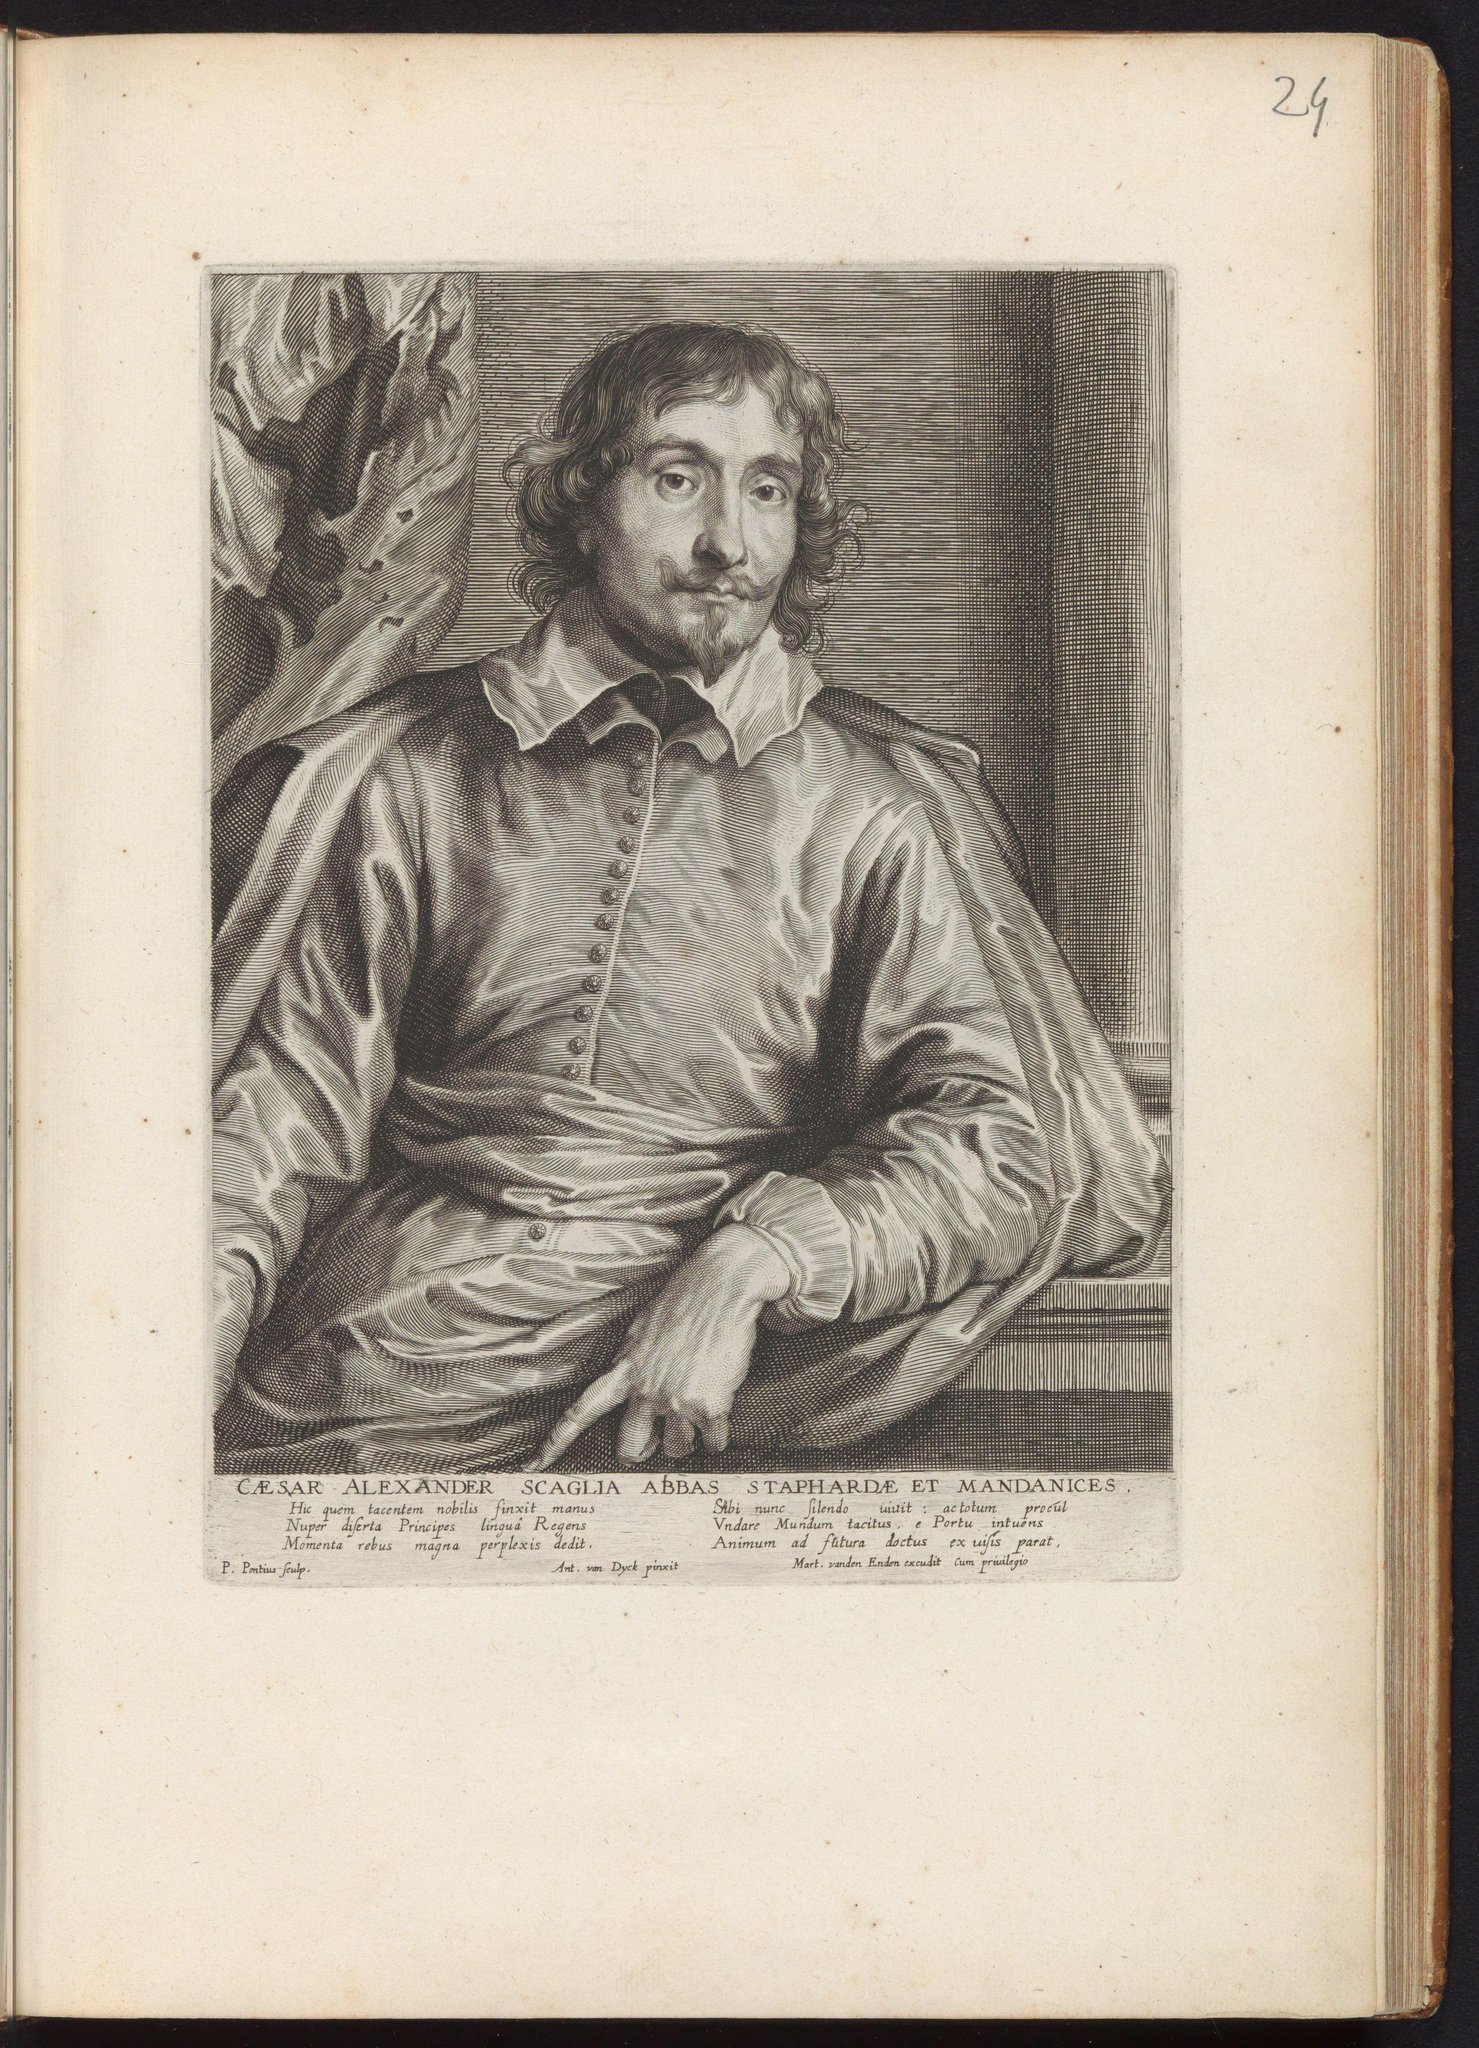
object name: album leaf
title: Iconographie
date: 1630-1641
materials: paper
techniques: engraving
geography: antwerp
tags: cesare alessandro scaglia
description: Deze prent maakt deel uit van een album.